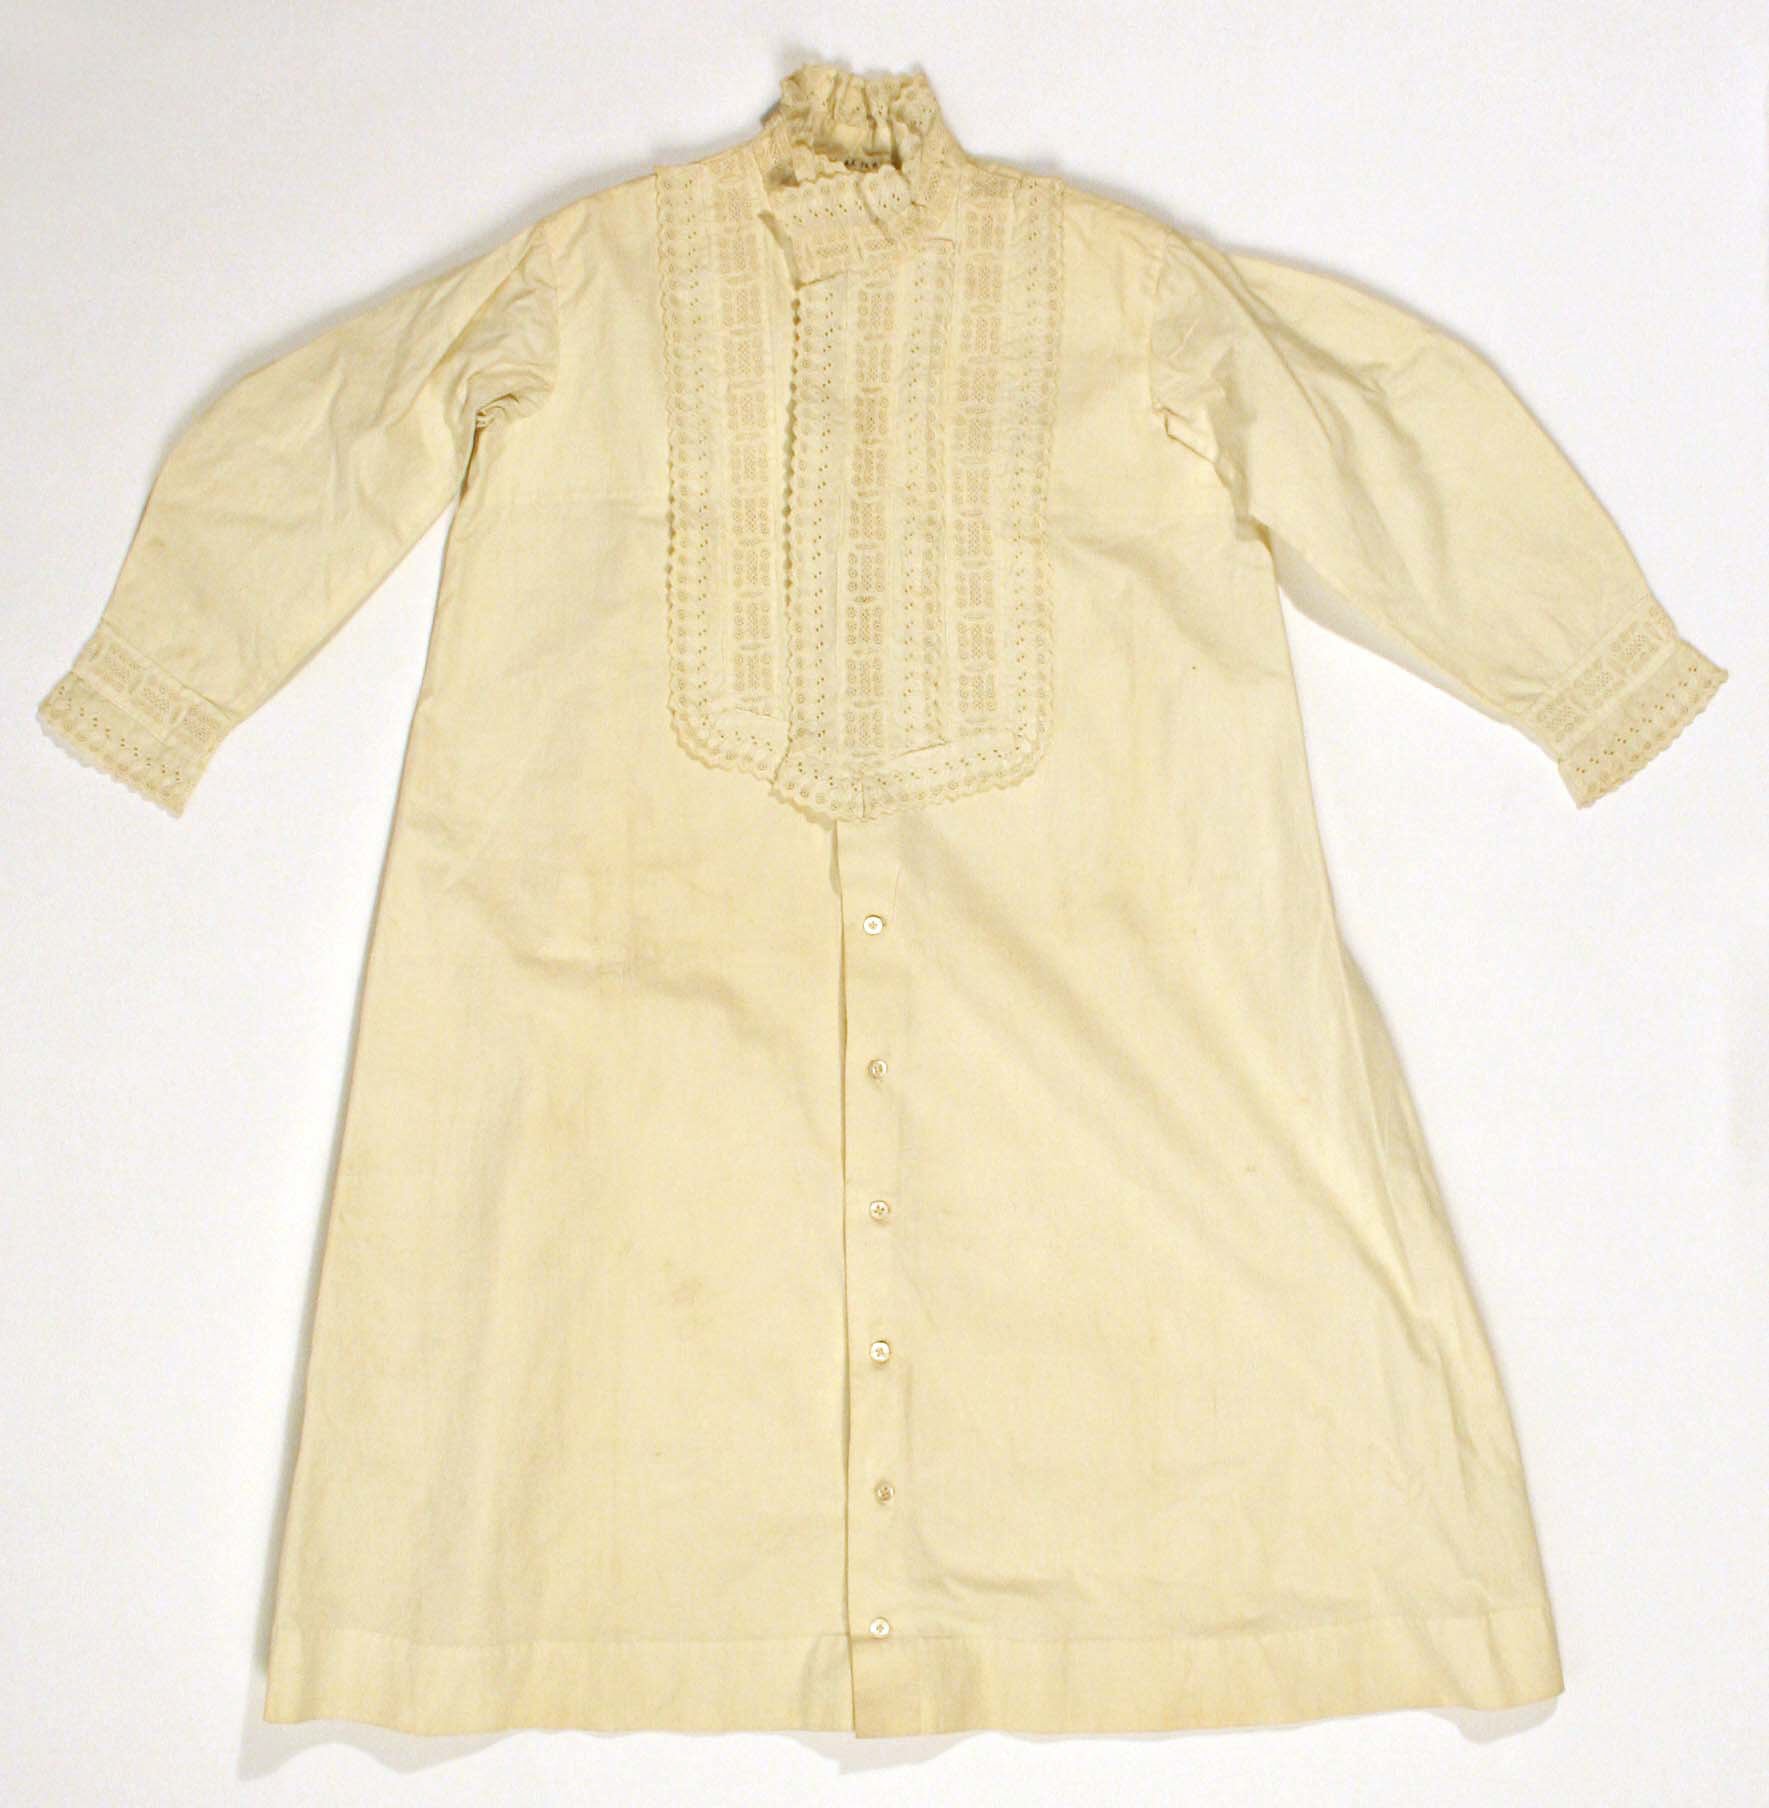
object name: nightgown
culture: american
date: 1880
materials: cotton